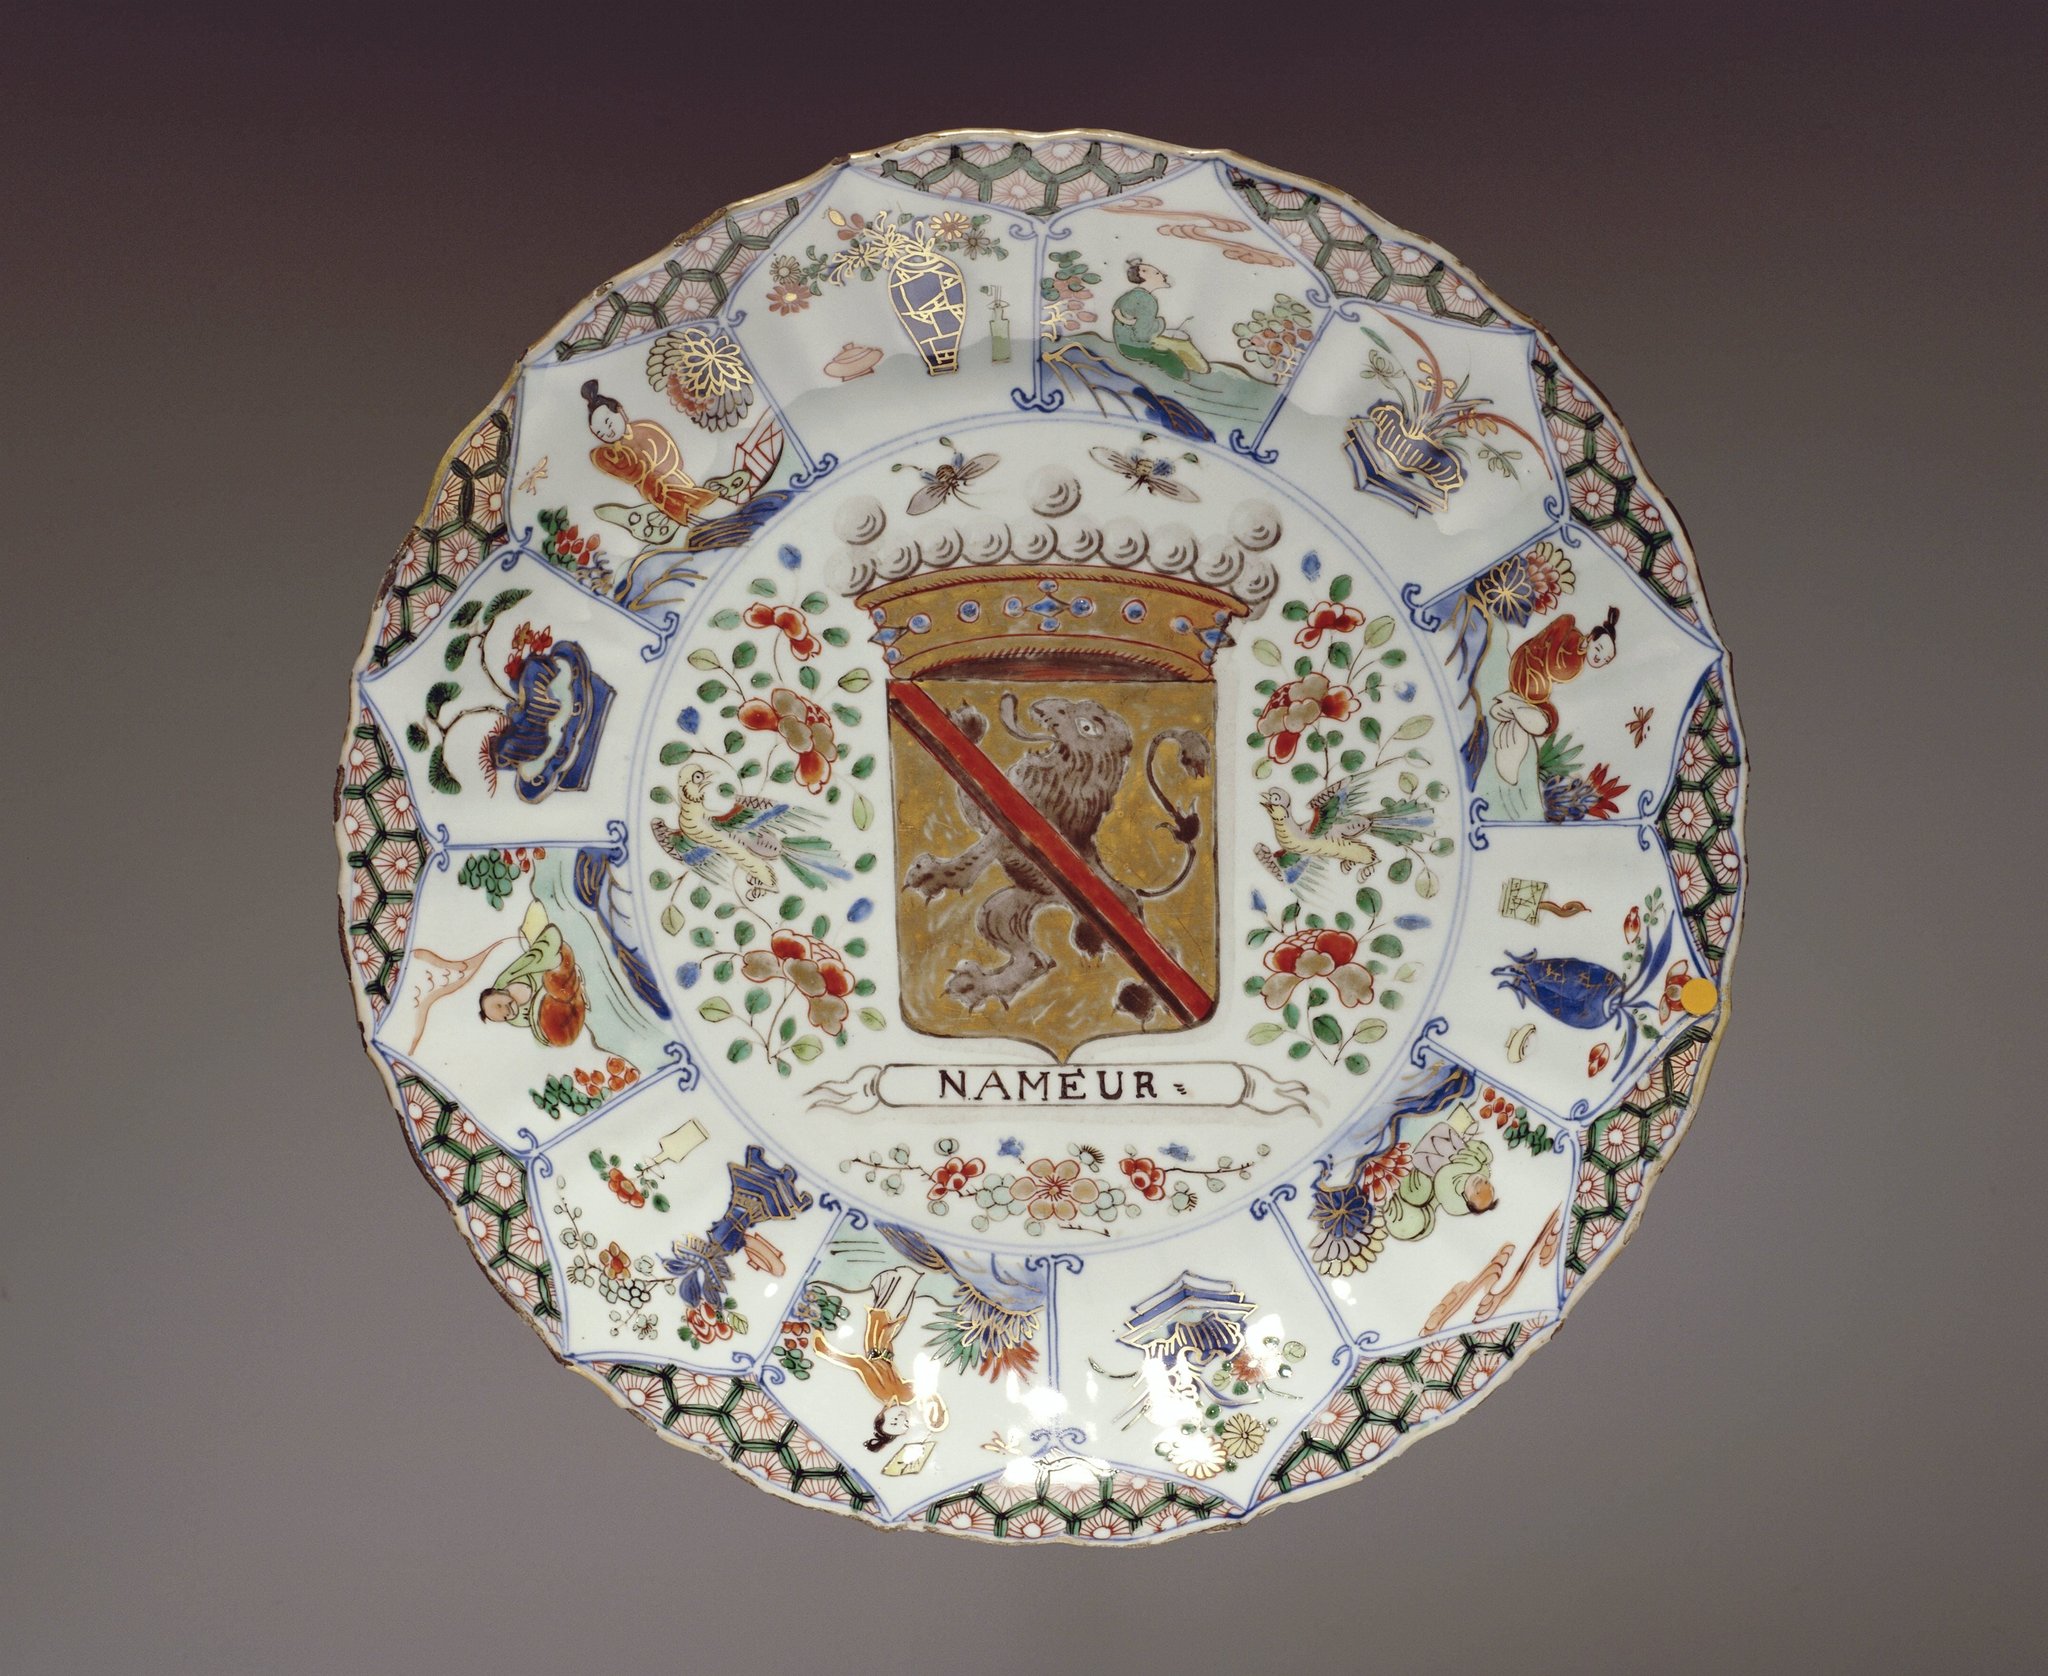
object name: platter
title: Dish with the arms of Namur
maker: Anonymous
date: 1700-1724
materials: cobalt, glaze, gold, paint, porcelain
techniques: firing, gilding, turning, vitrification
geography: china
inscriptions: inscription: ‘Nameur’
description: Schotel van porselein met geribde wand en geschulpte rand, beschilderd in onderglazuur blauw en op het glazuur blauw, rood, groen, geel, zwart en goud. Op het plat in een medaillon het wapen van Namur met daaronder het opschrift 'Nameur', om het wapen bloemtakken, twee vlinders en twee vogels. De wand is verdeeld in twaalf bloembladvormige vakken met afwisselend een bloemenvaas en een persoon in een landschap; tussen de vakken servetwerk. De achterzijde met twee bloemtakken. Twee barsten in de wand. Wapenporselein met famille verte emailkleuren.